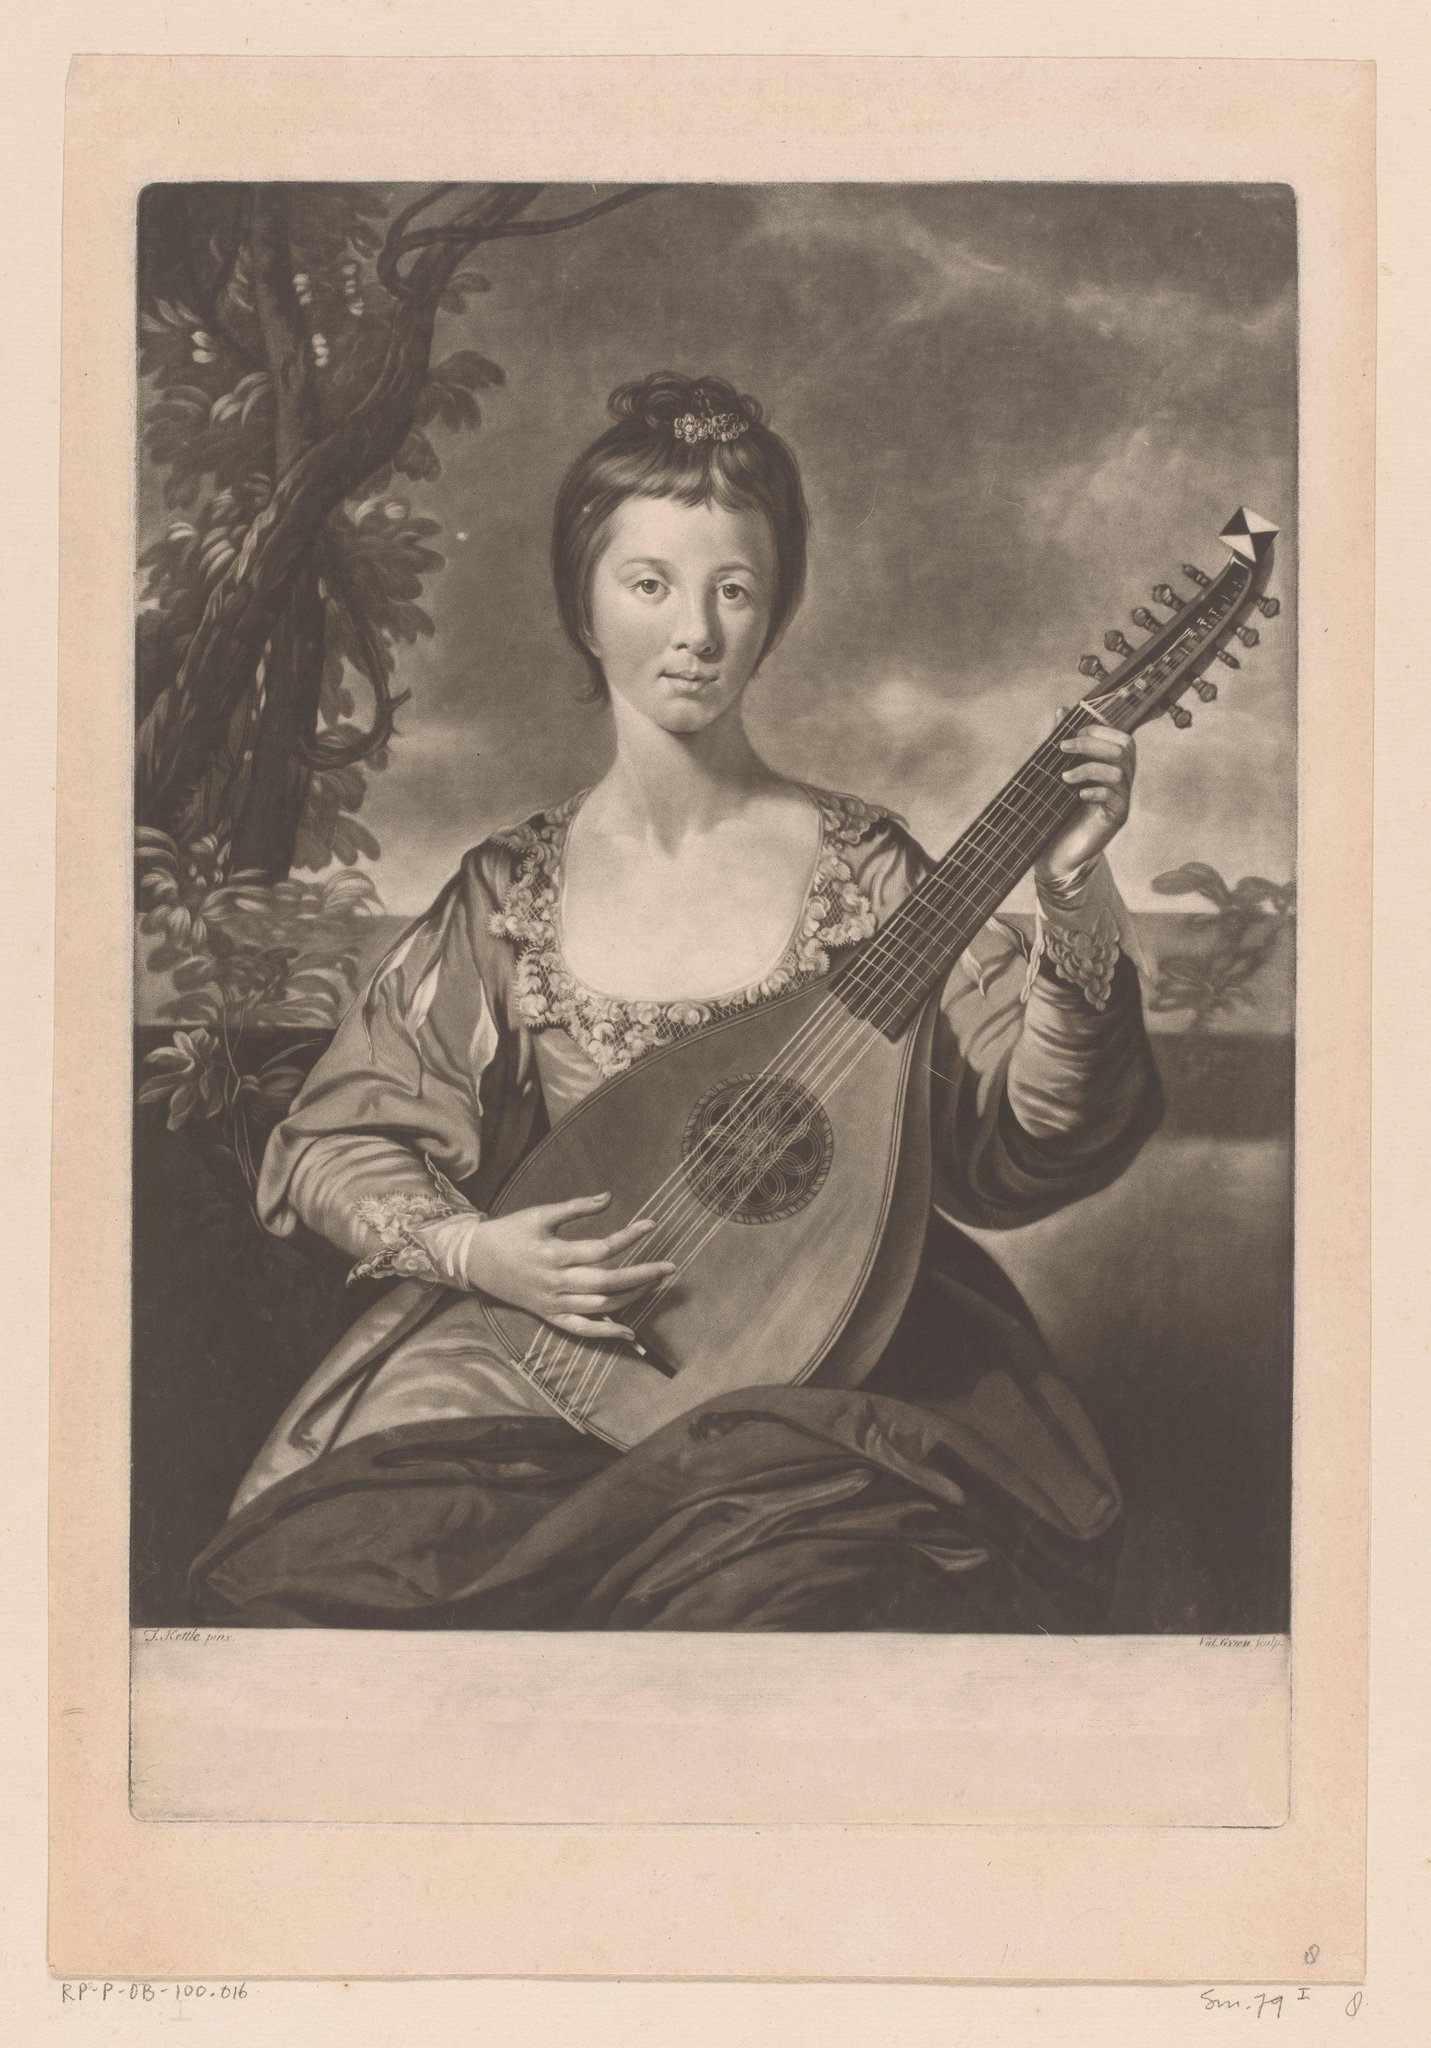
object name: print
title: Portret van mevrouw Kettle met luit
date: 1749-1813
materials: paper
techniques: mezzotint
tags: historical persons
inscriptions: collector's mark: Lugt 240